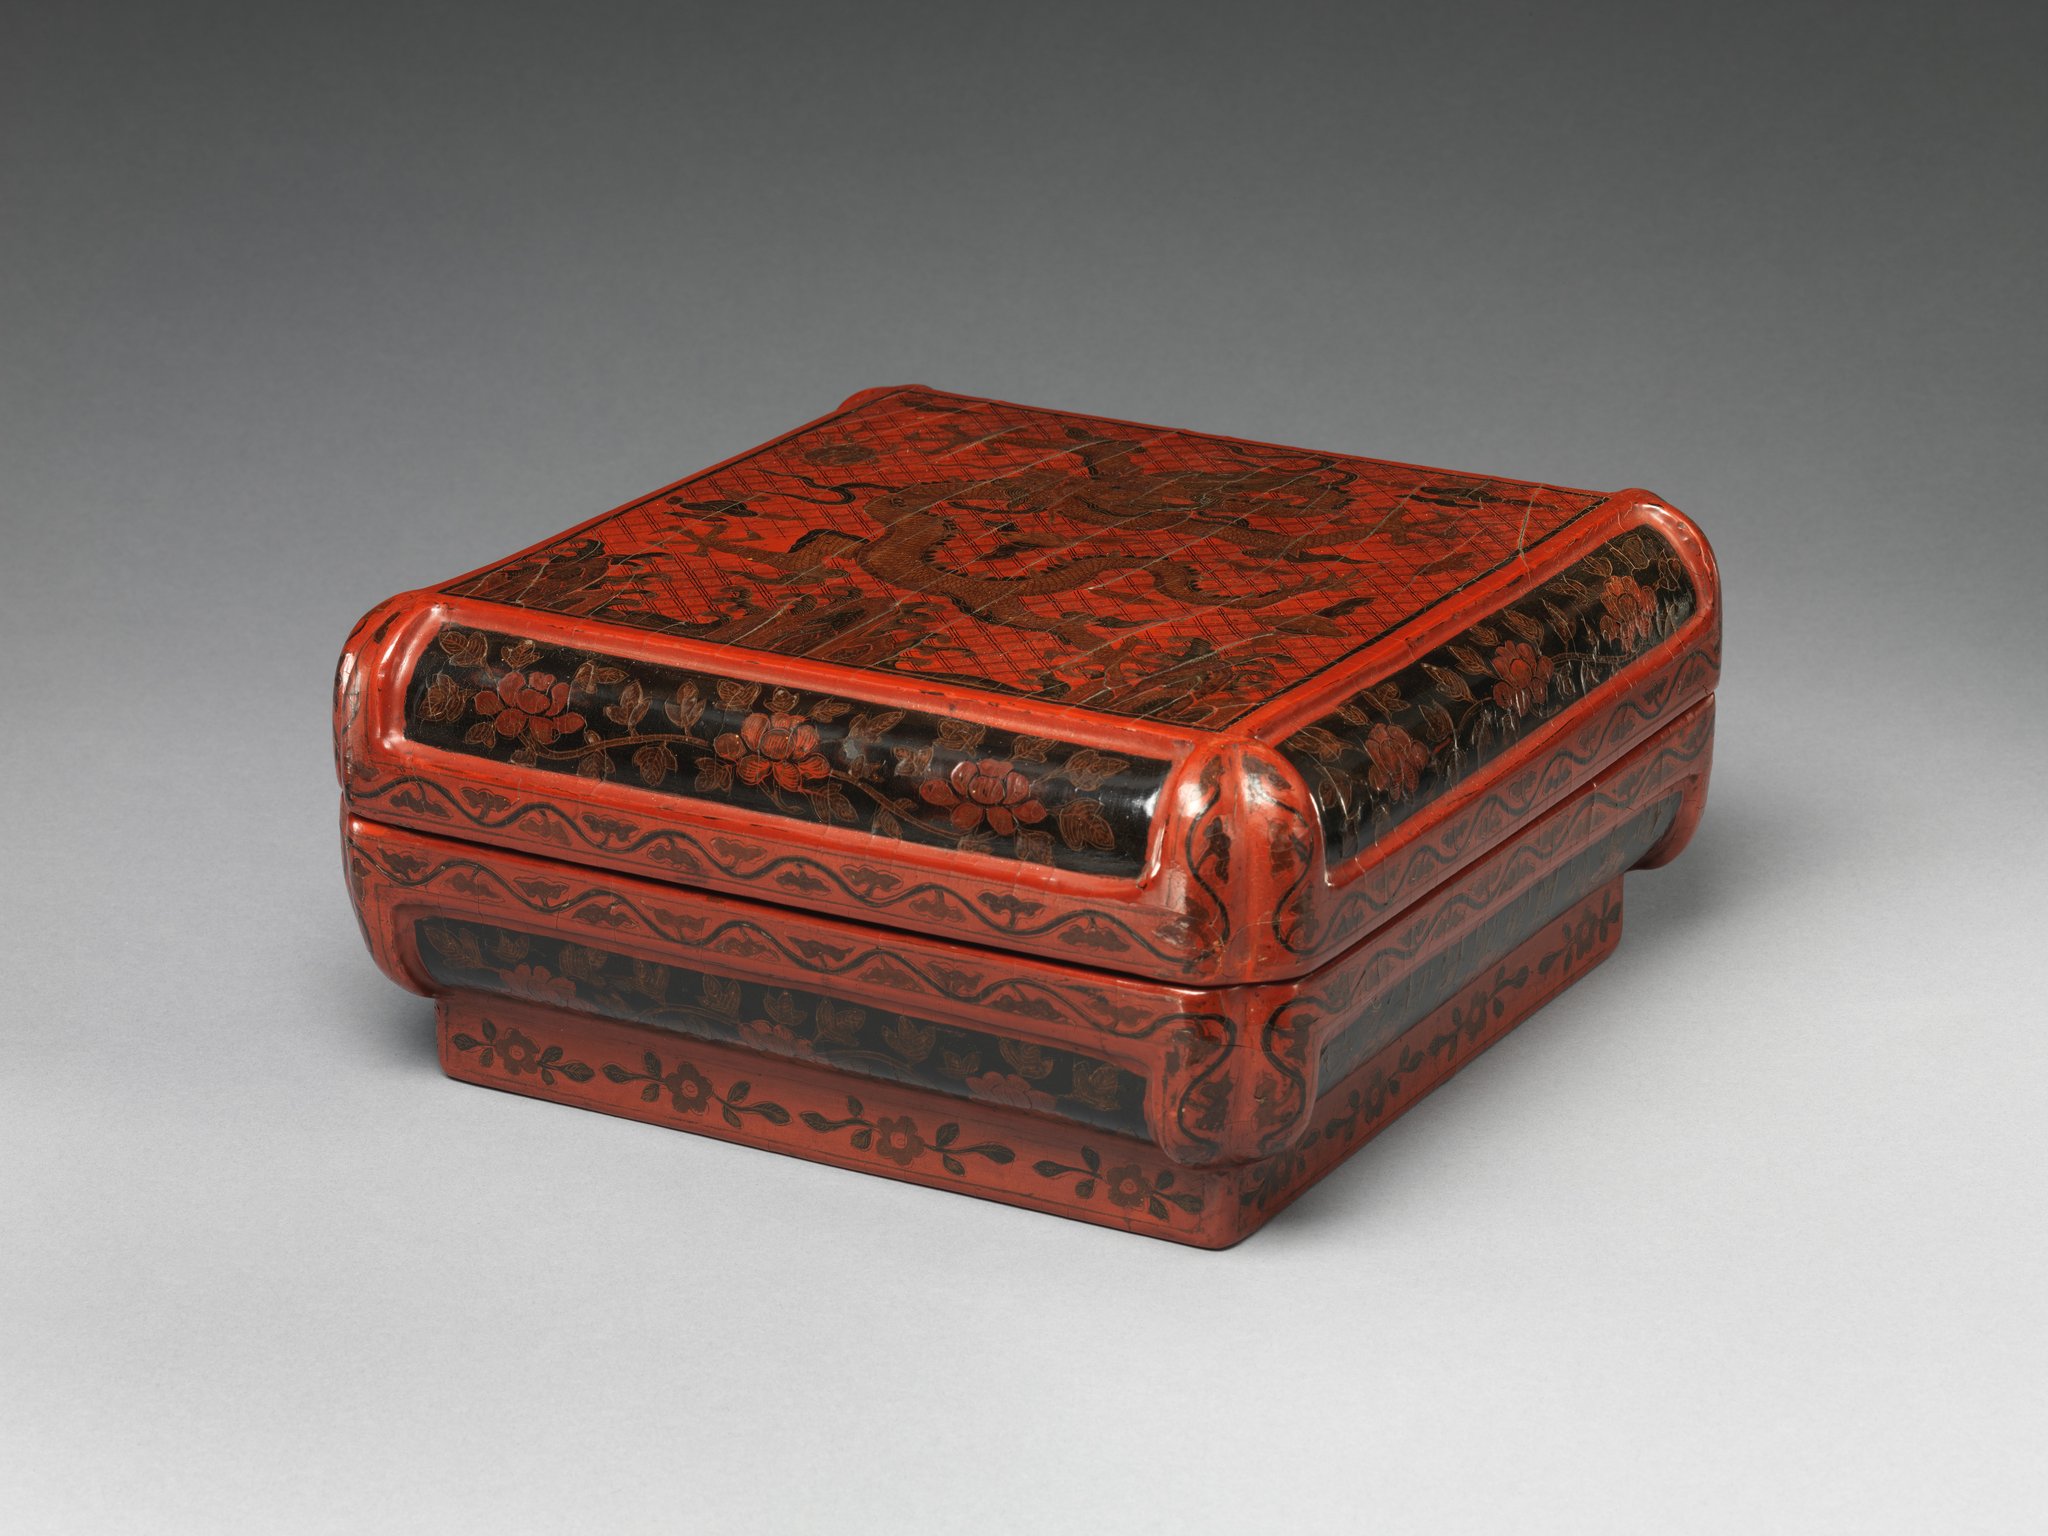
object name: box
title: Covered square box with dragon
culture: chinese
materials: gold, lacquer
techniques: engraving, polychrome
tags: dragons